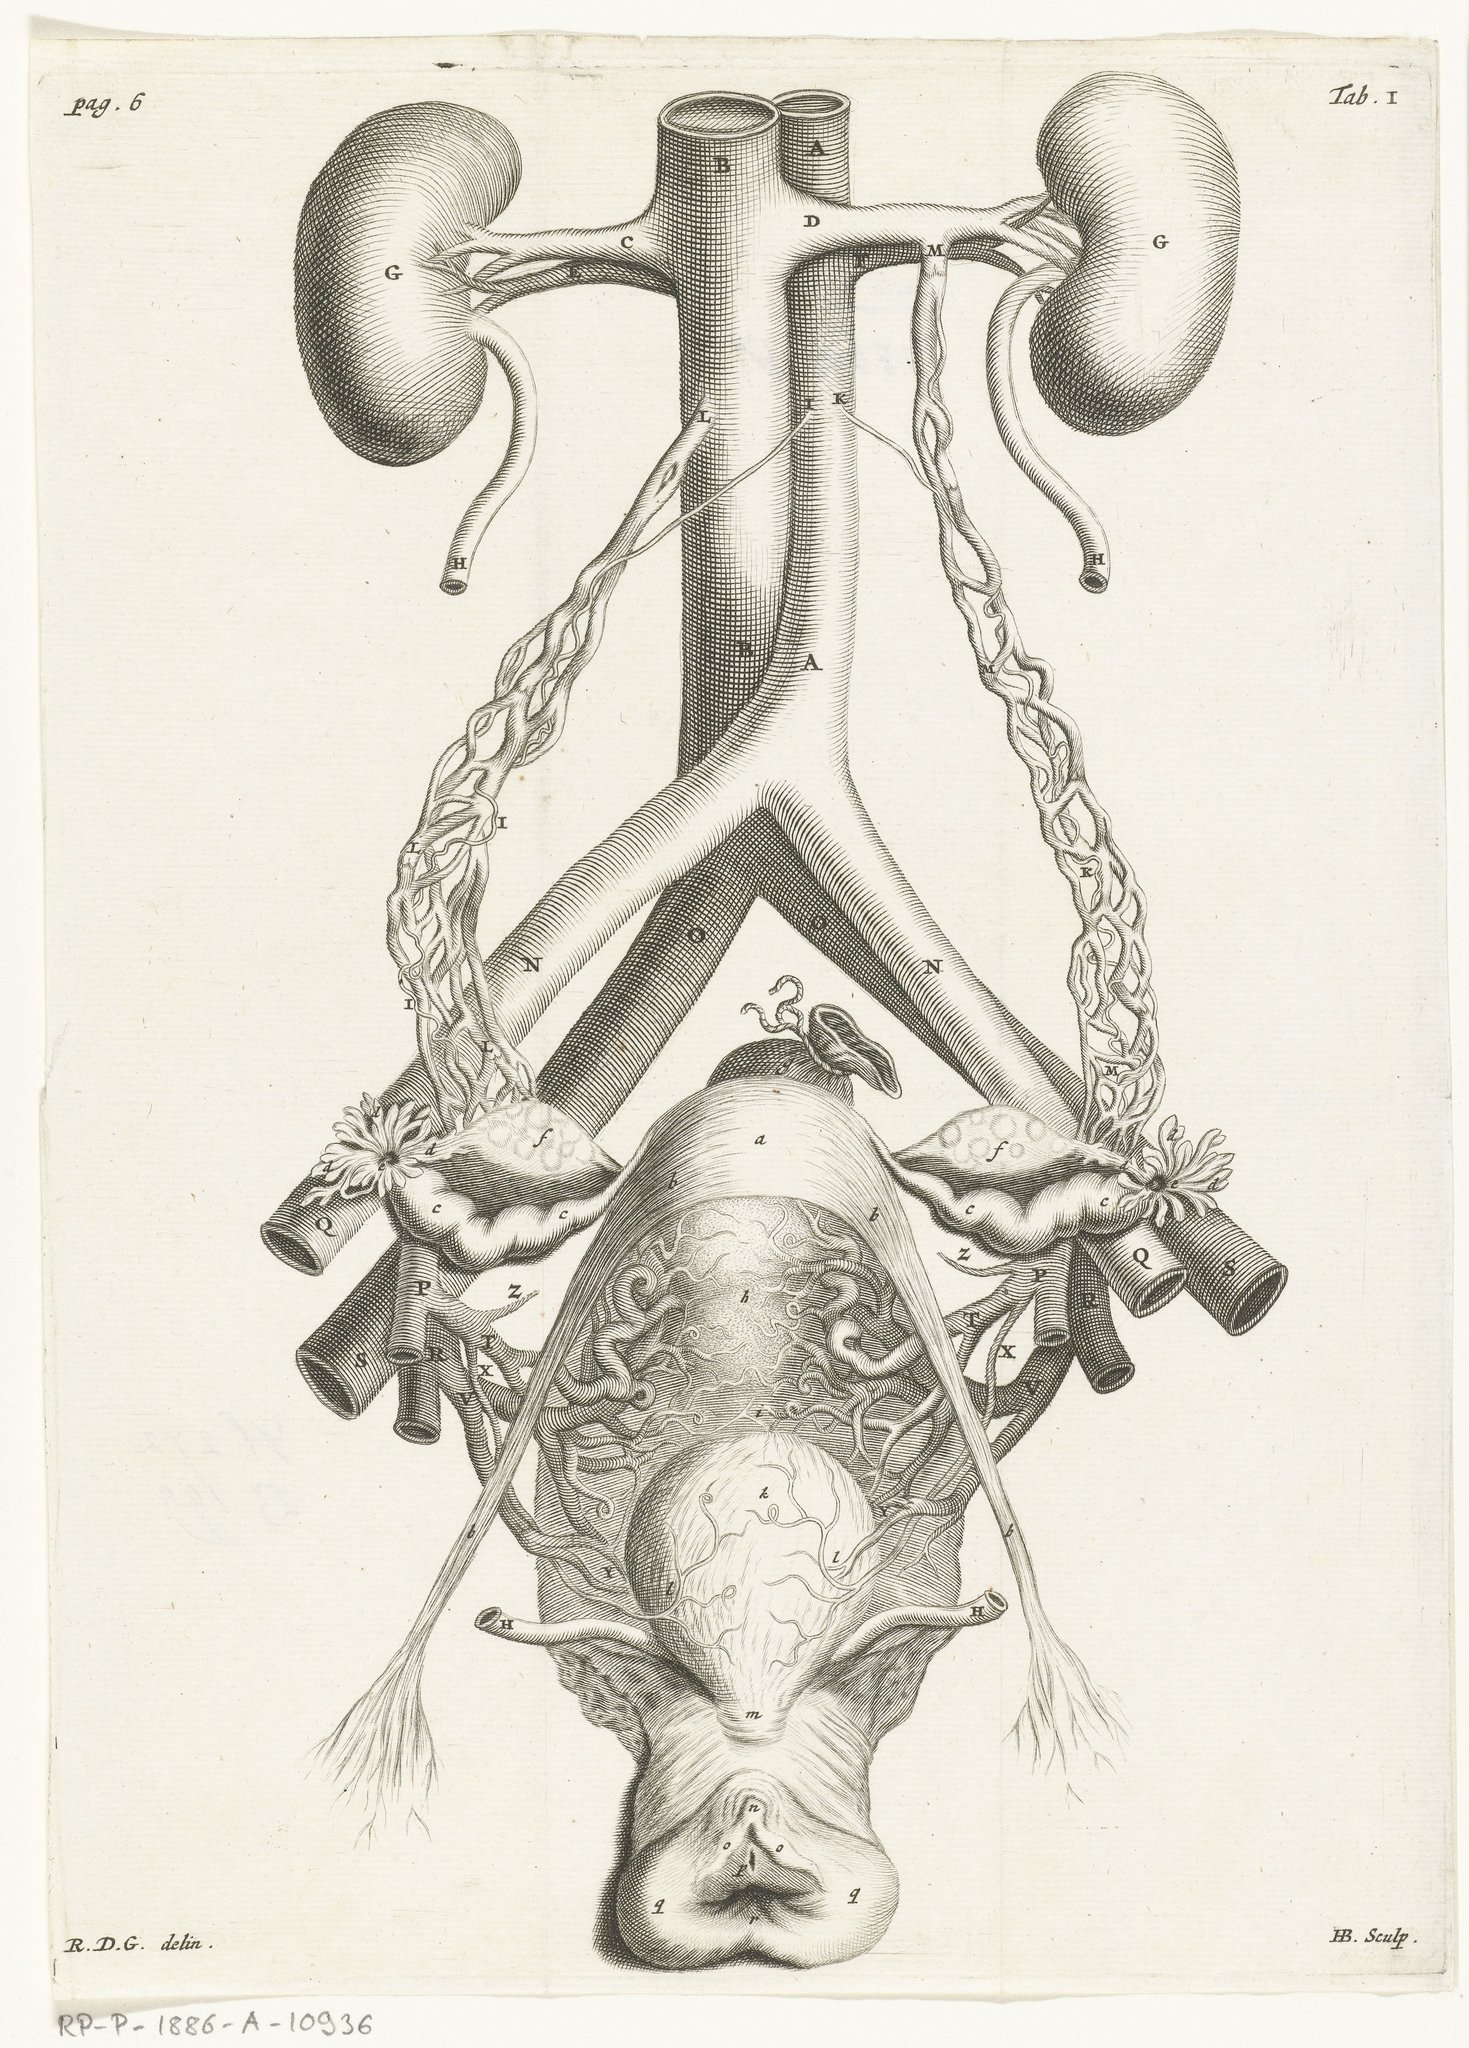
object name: book illustration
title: Anatomische afbeelding van de vrouwelijke geslachtsorganen en de nieren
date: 1672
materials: paper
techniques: engraving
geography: netherlands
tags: female sexual organs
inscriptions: collector's mark: Lugt 2228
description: Illustratie voor: Reinier de Graaf, De mulierum organis generationi inservientibus tractatus novus, Leiden, ex officina Hackiana, 1672